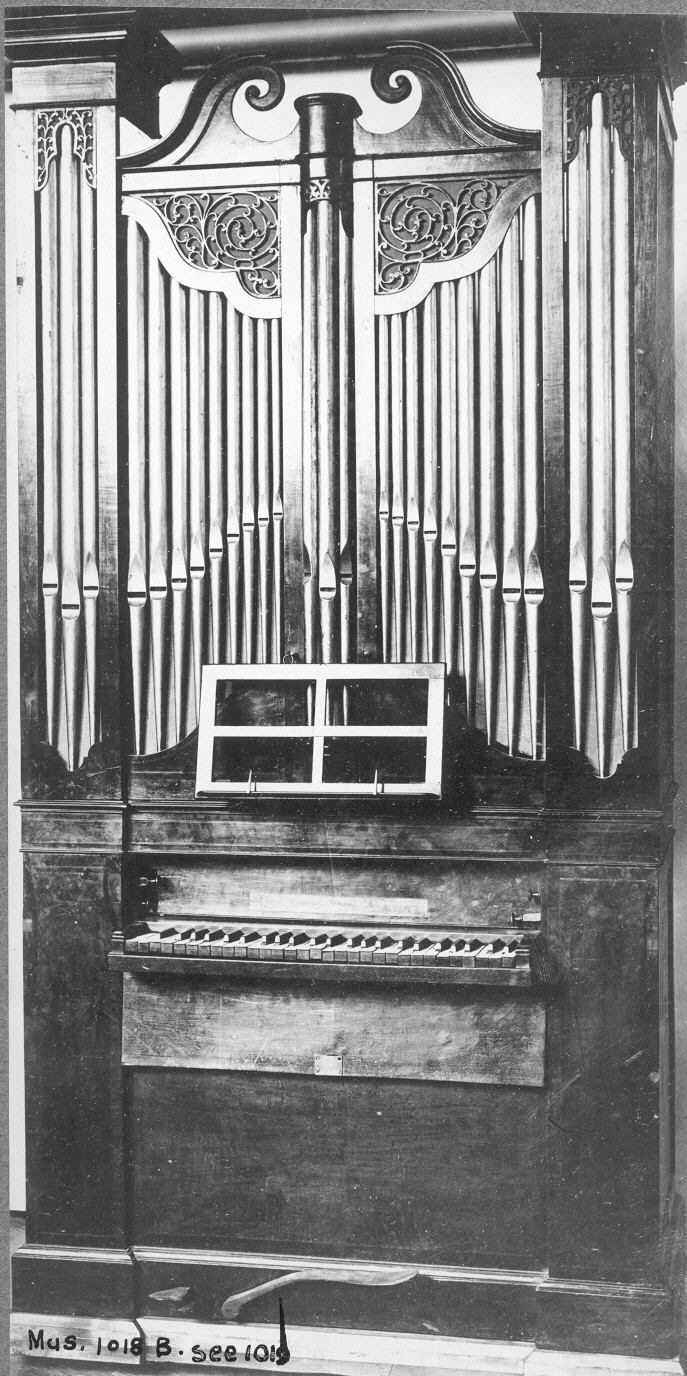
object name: chamber organ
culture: british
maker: thomas chapman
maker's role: maker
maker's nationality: british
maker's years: 1775-1785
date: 1779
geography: united kingdom